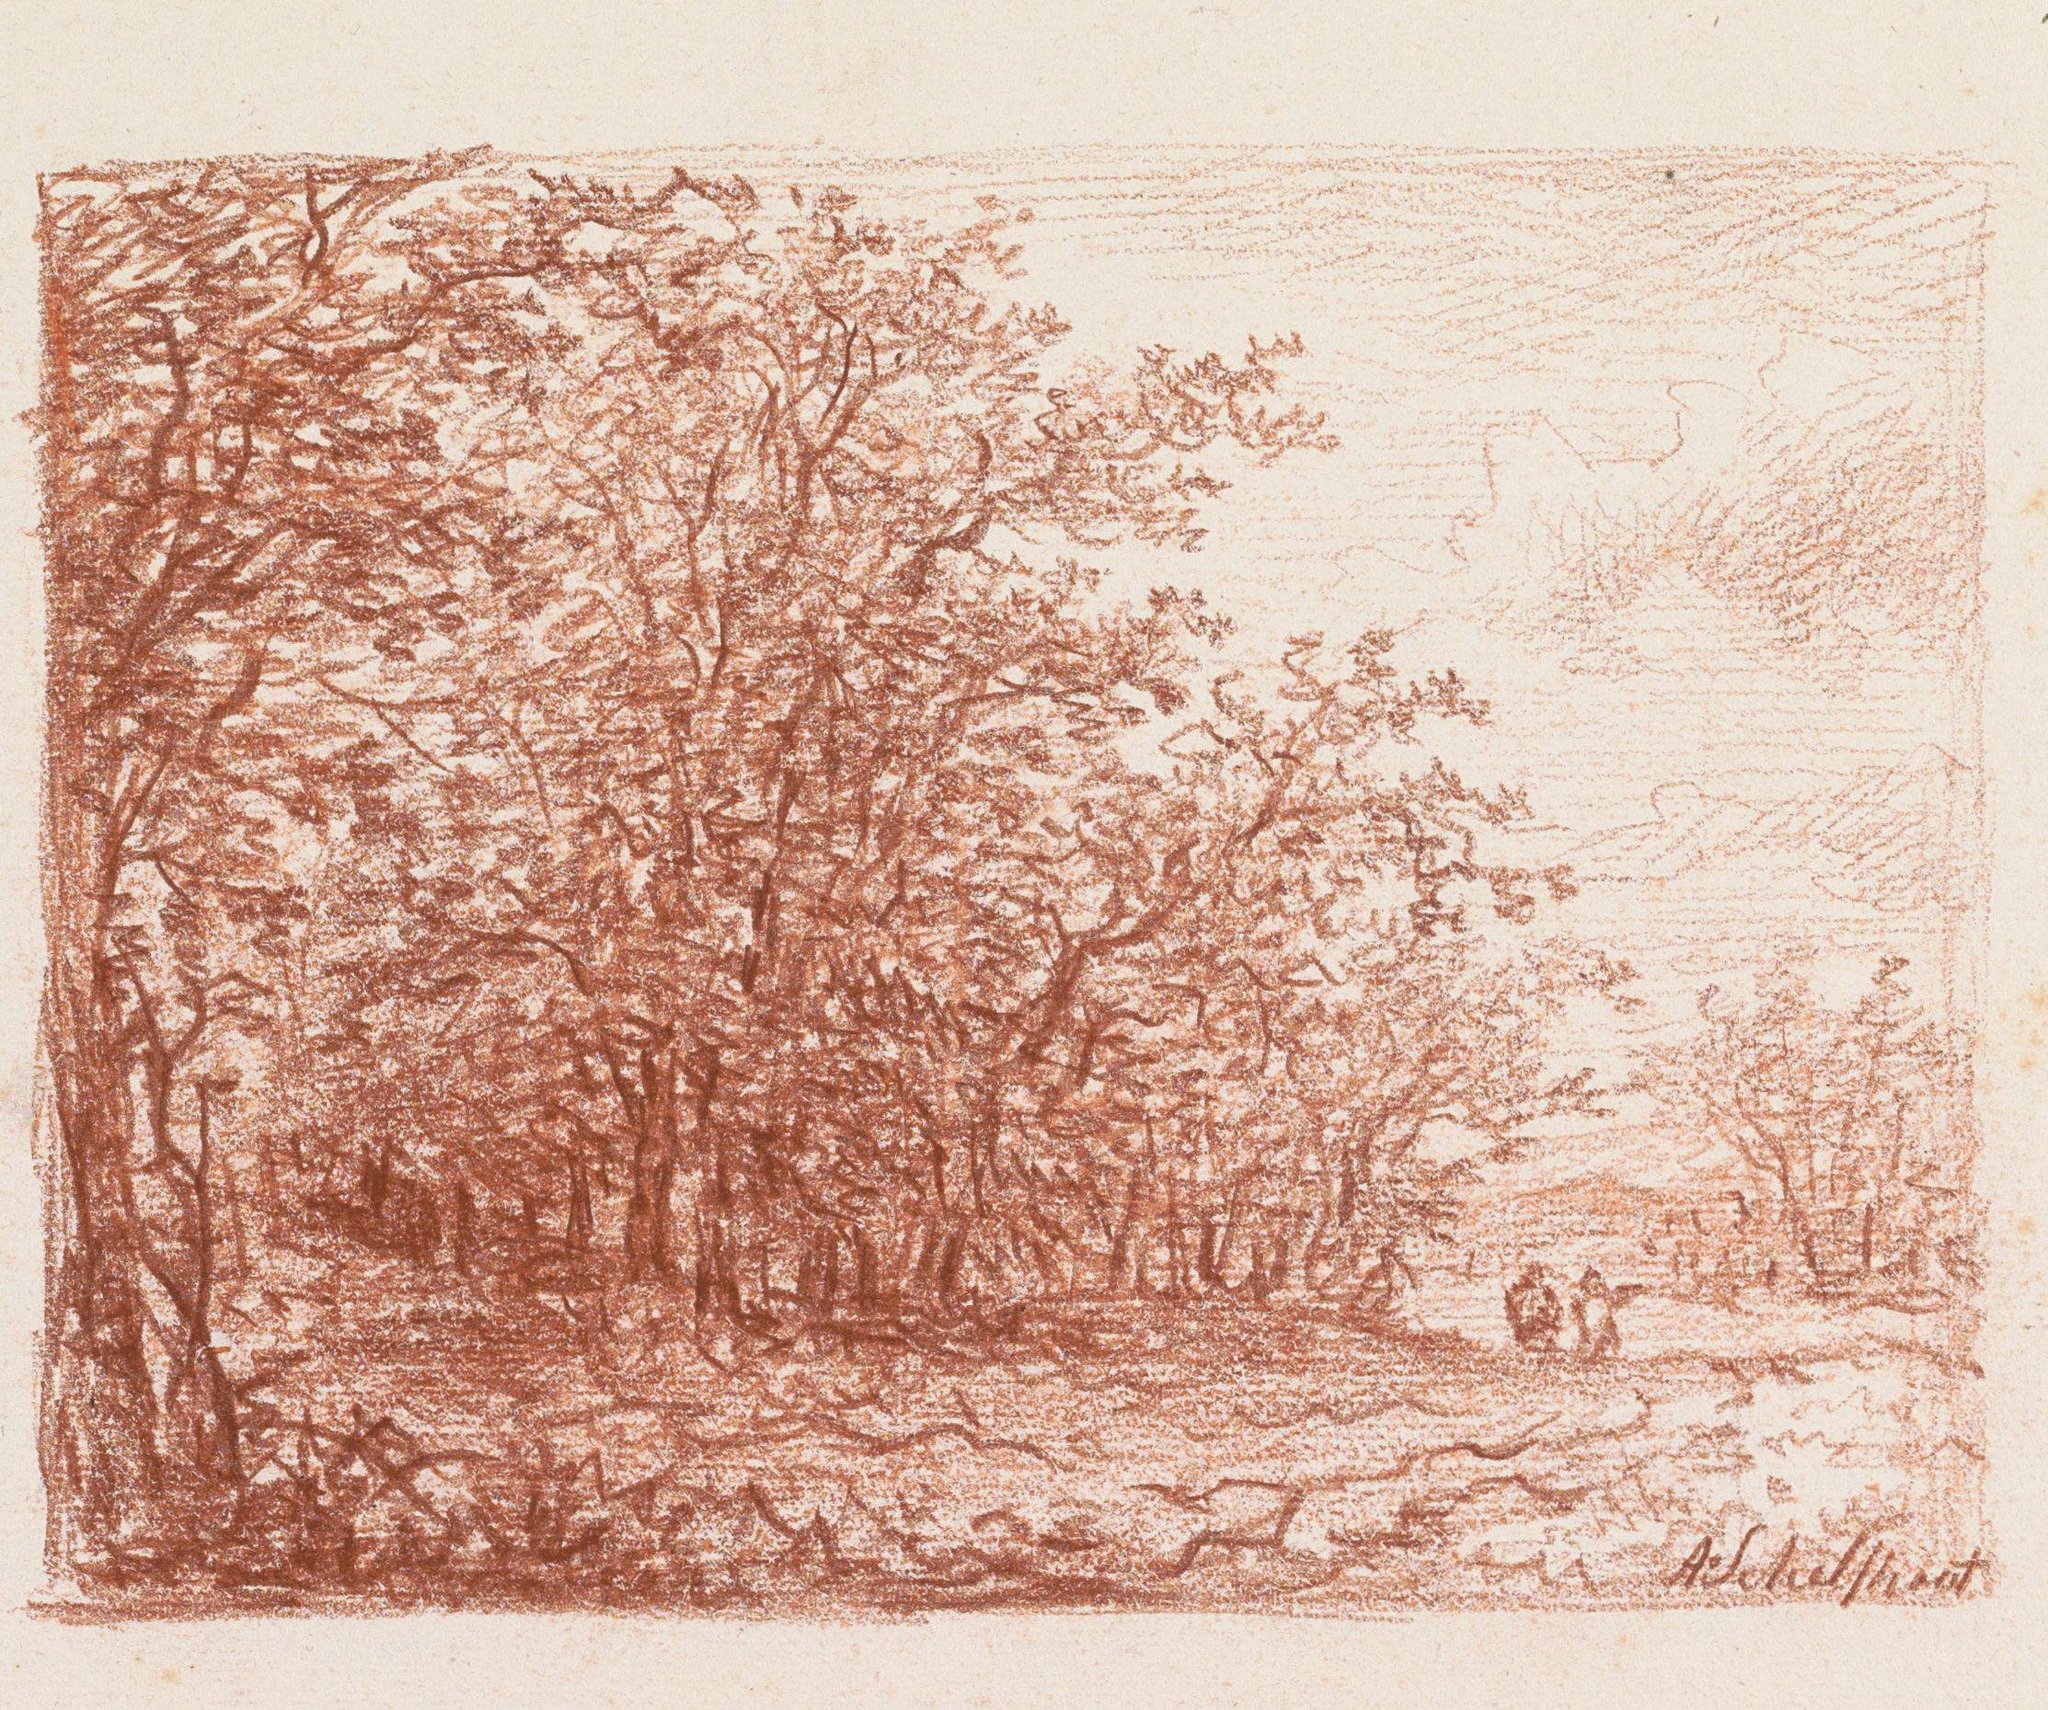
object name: sketchbook leaf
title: Landschap met bomen en twee wandelaars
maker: andreas schelfhout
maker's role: draughtsman, painter, print maker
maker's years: 1787-1870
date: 1811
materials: chalk, paper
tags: landscapes (+ landscape with figures, staffage)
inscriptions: signature: ‘A. Schelfhout’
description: Blad 3 recto uit een schetsboek met 75 bladen.